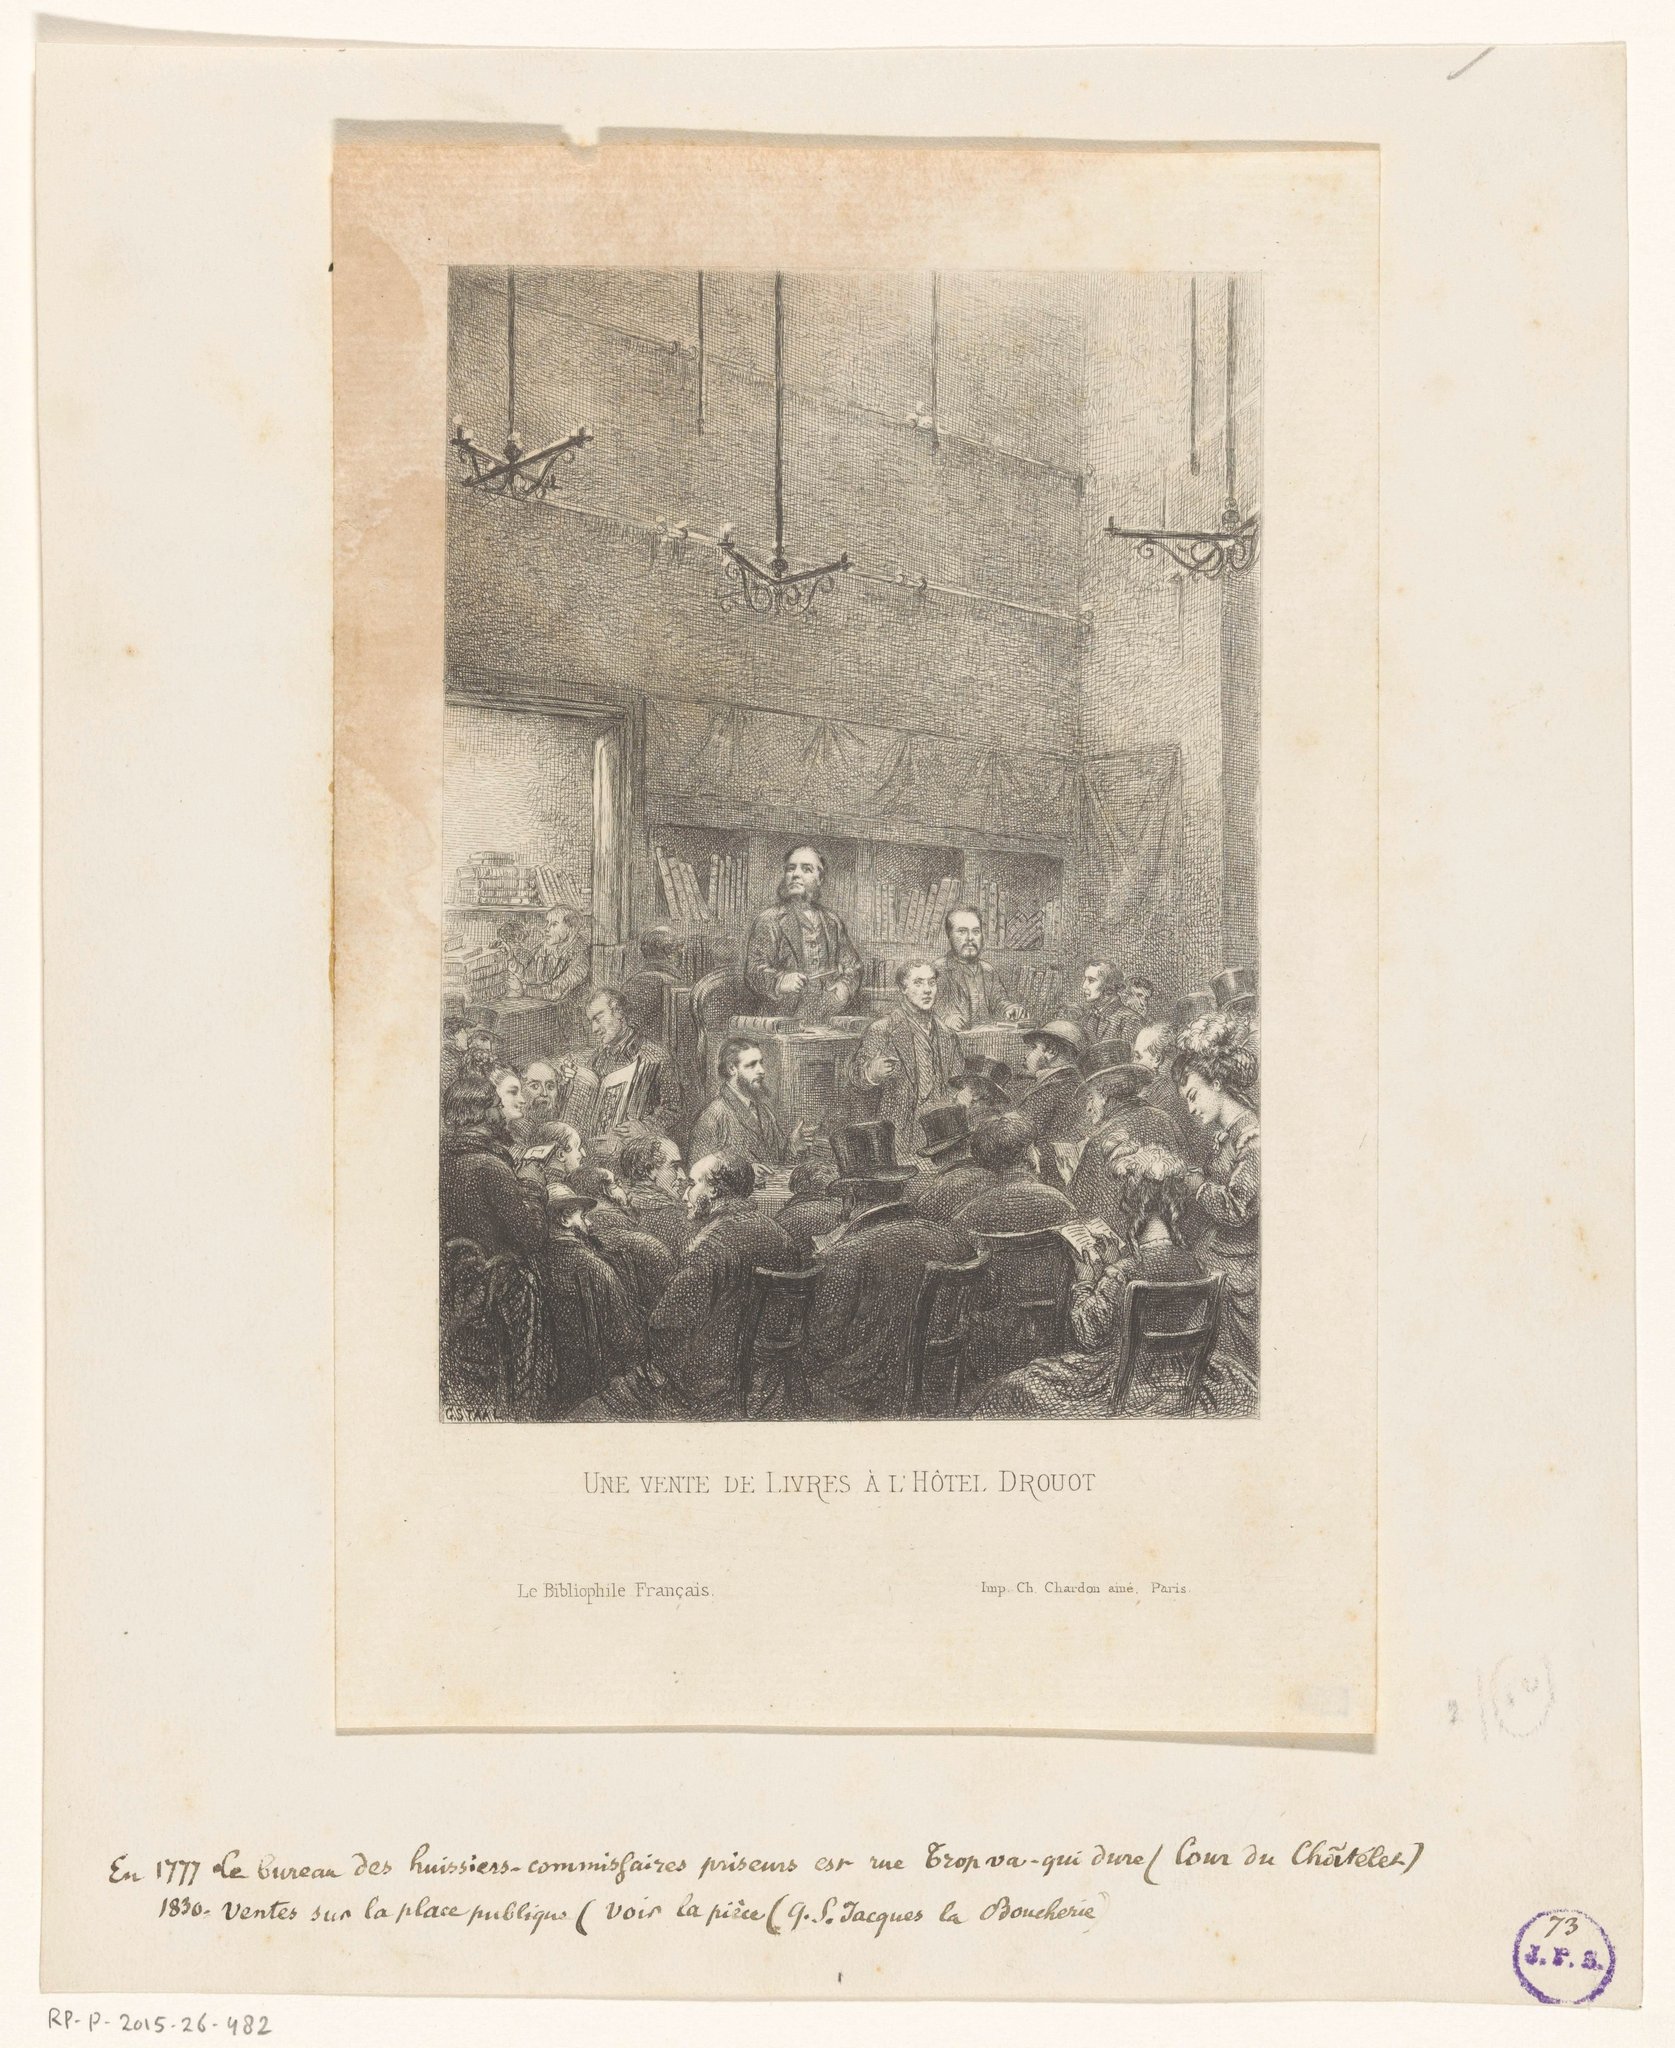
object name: print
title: Une vent de livres à l'Hôtel Drouot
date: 1862-1874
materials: paper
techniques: etching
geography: paris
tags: bookshelves, book, art sale, auction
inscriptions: collector's mark: Lugt 2228, collector's mark, collector's mark: ‘J.P.S.’, annotation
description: Interieur van de veilingzaal, de kopers gezeten op stoelen of staand in de zaal. In het midden de veilingmeester op een verhoging, rechts van hem houdt een man een boek open voor enkele geïnteresseerden.